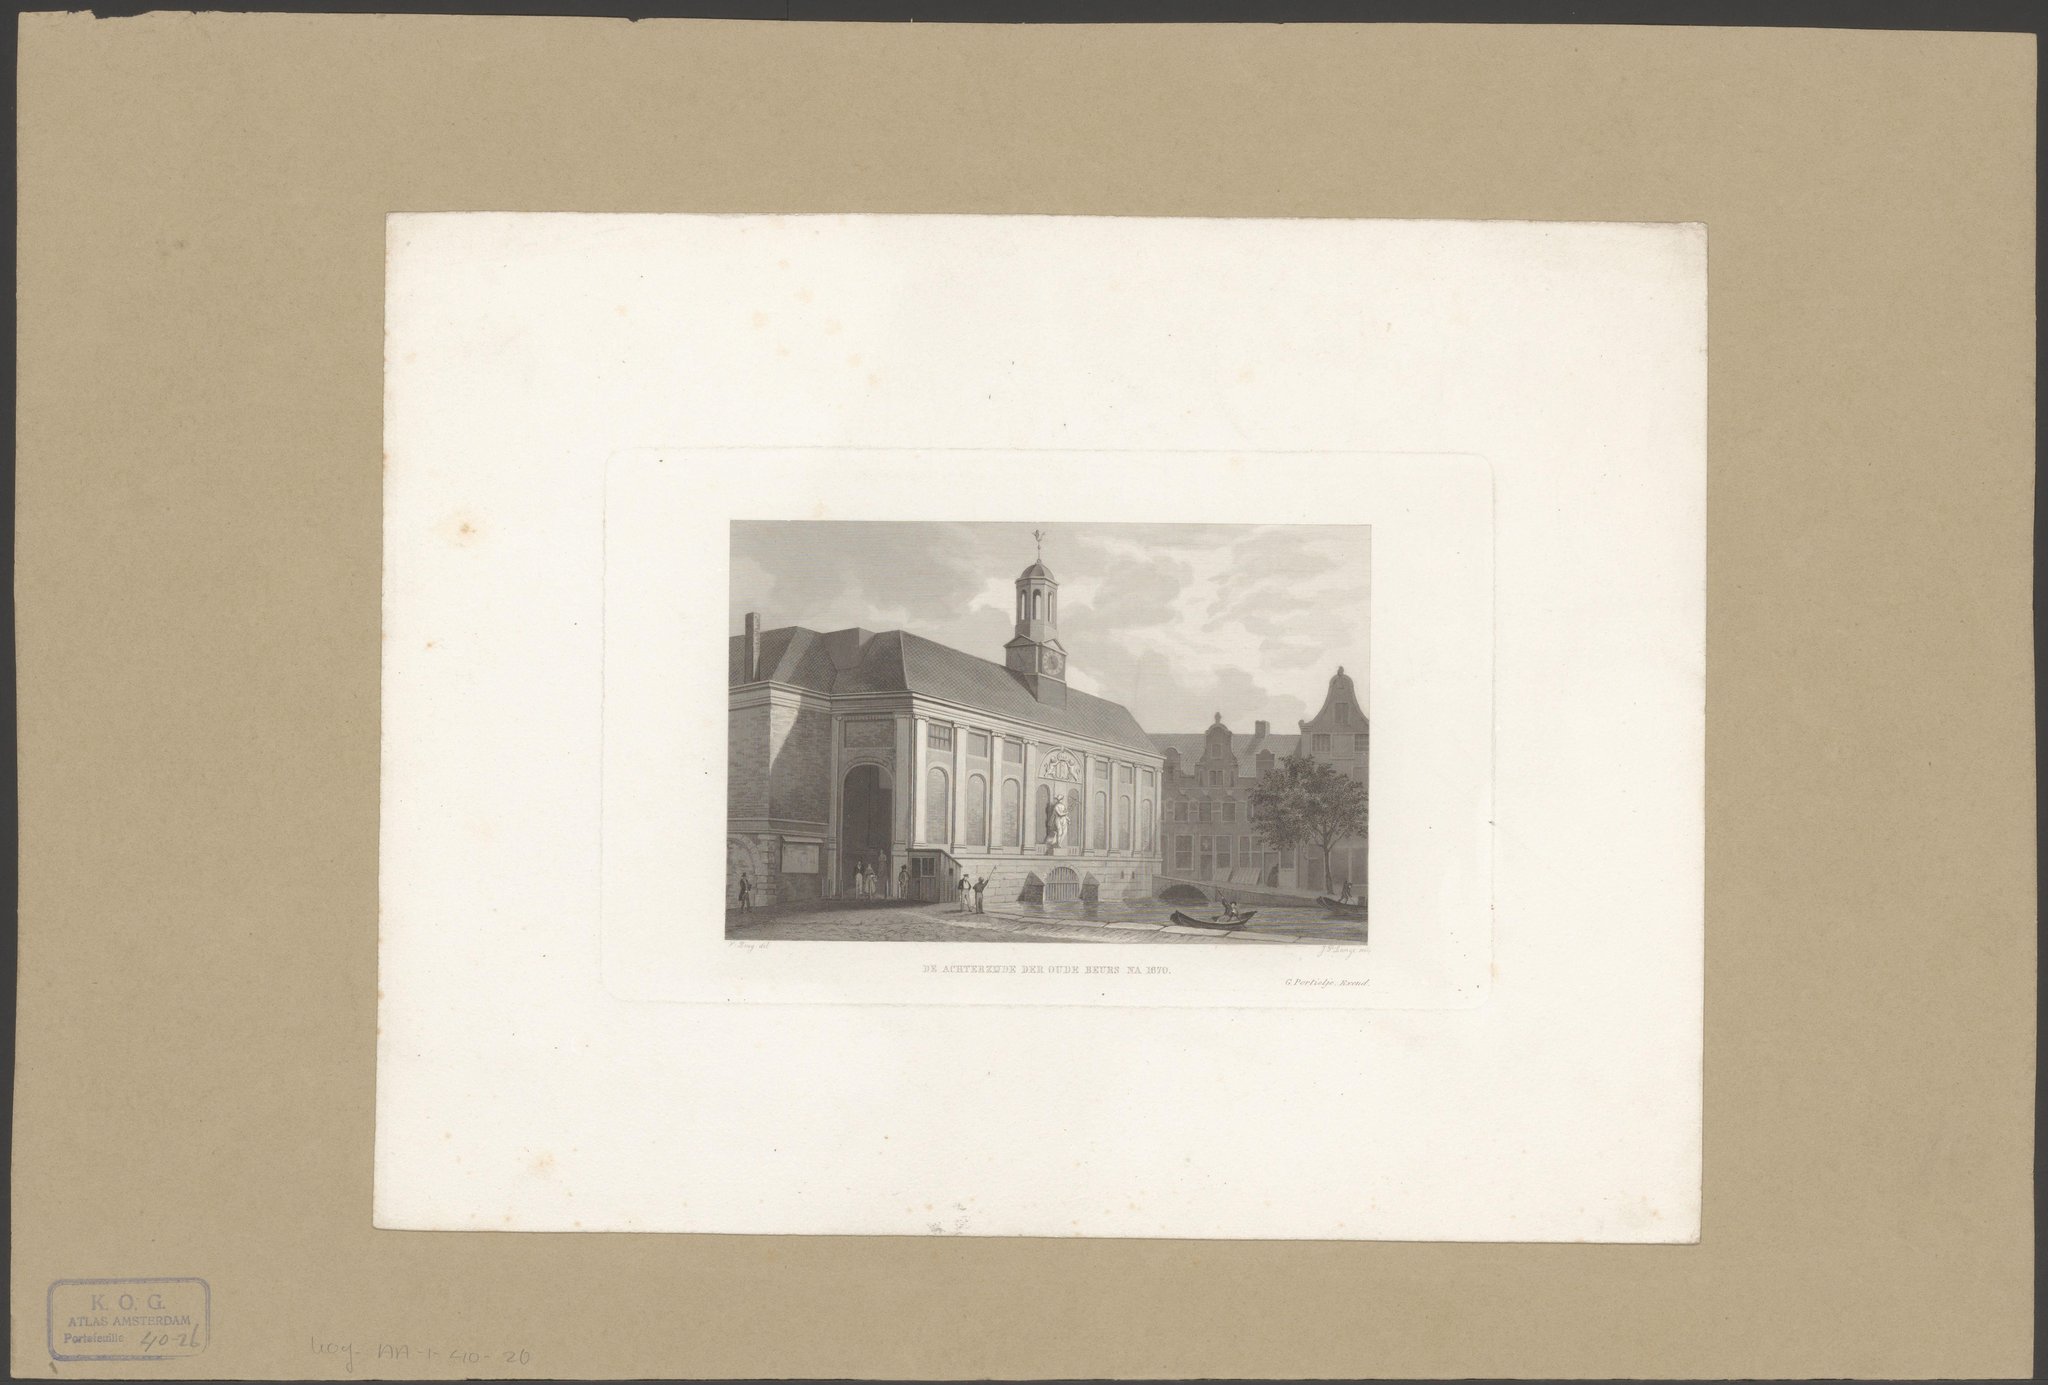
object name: print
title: Gezicht op de achterzijde van de Beurs van Hendrik de Keyser te Amsterdam, na 1670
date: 1846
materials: paper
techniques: engraving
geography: amsterdam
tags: stock exchange, stock-market, rowing-boat, canoe, etc., canals, waters (in city) (+ city(-scape) with figures, staffage)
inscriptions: collector's mark: Lugt 1641b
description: Onderdeel van losse uitgave van prenten uit: Scheltema, Pieter. De Beurs van Amsterdam. Amsterdam: Gerrit Portielje, 1846.